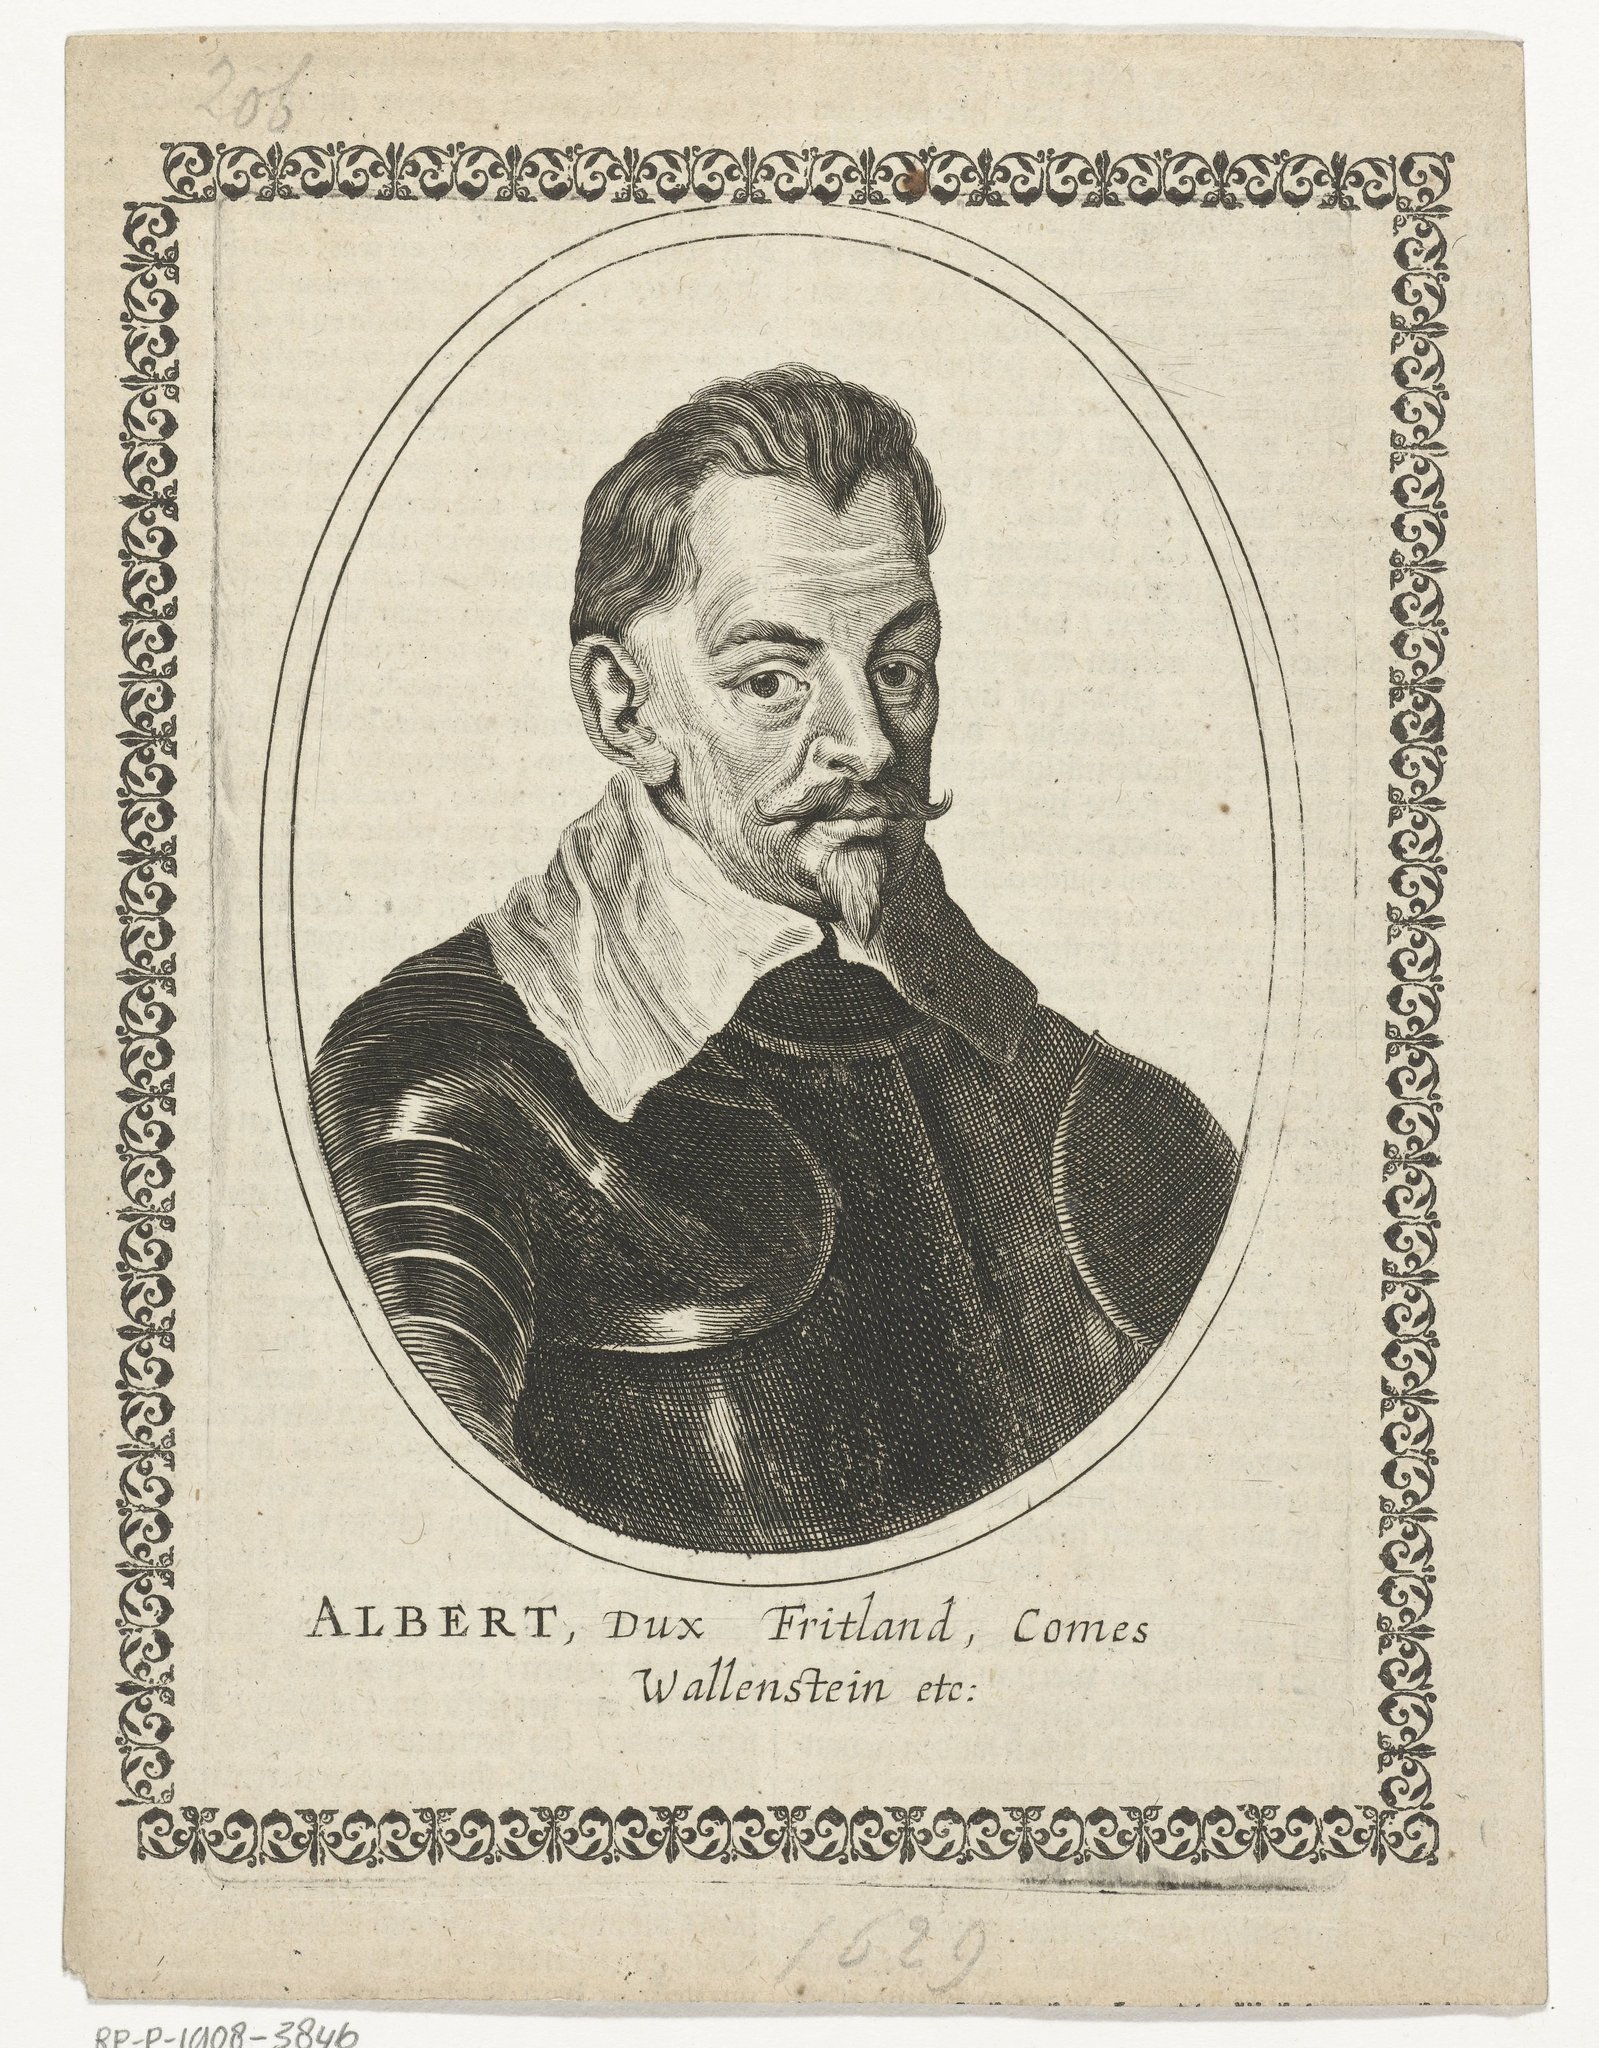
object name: book illustration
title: Albert, Dux Fritland, Comes Wallenstein etc:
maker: cornelis danckerts (i)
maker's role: print maker, publisher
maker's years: 1604-1656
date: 1613-1656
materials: paper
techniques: engraving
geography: netherlands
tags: albrecht von wallenstein (hertog van friedland)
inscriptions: collector's mark: Lugt 2228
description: Prent gebruikt als boekillustratie in onbekende uitgave, mogelijk gedateerd 1629 op basis van handgeschreven datering in ondermarge. Niet beschreven bij Hollstein.